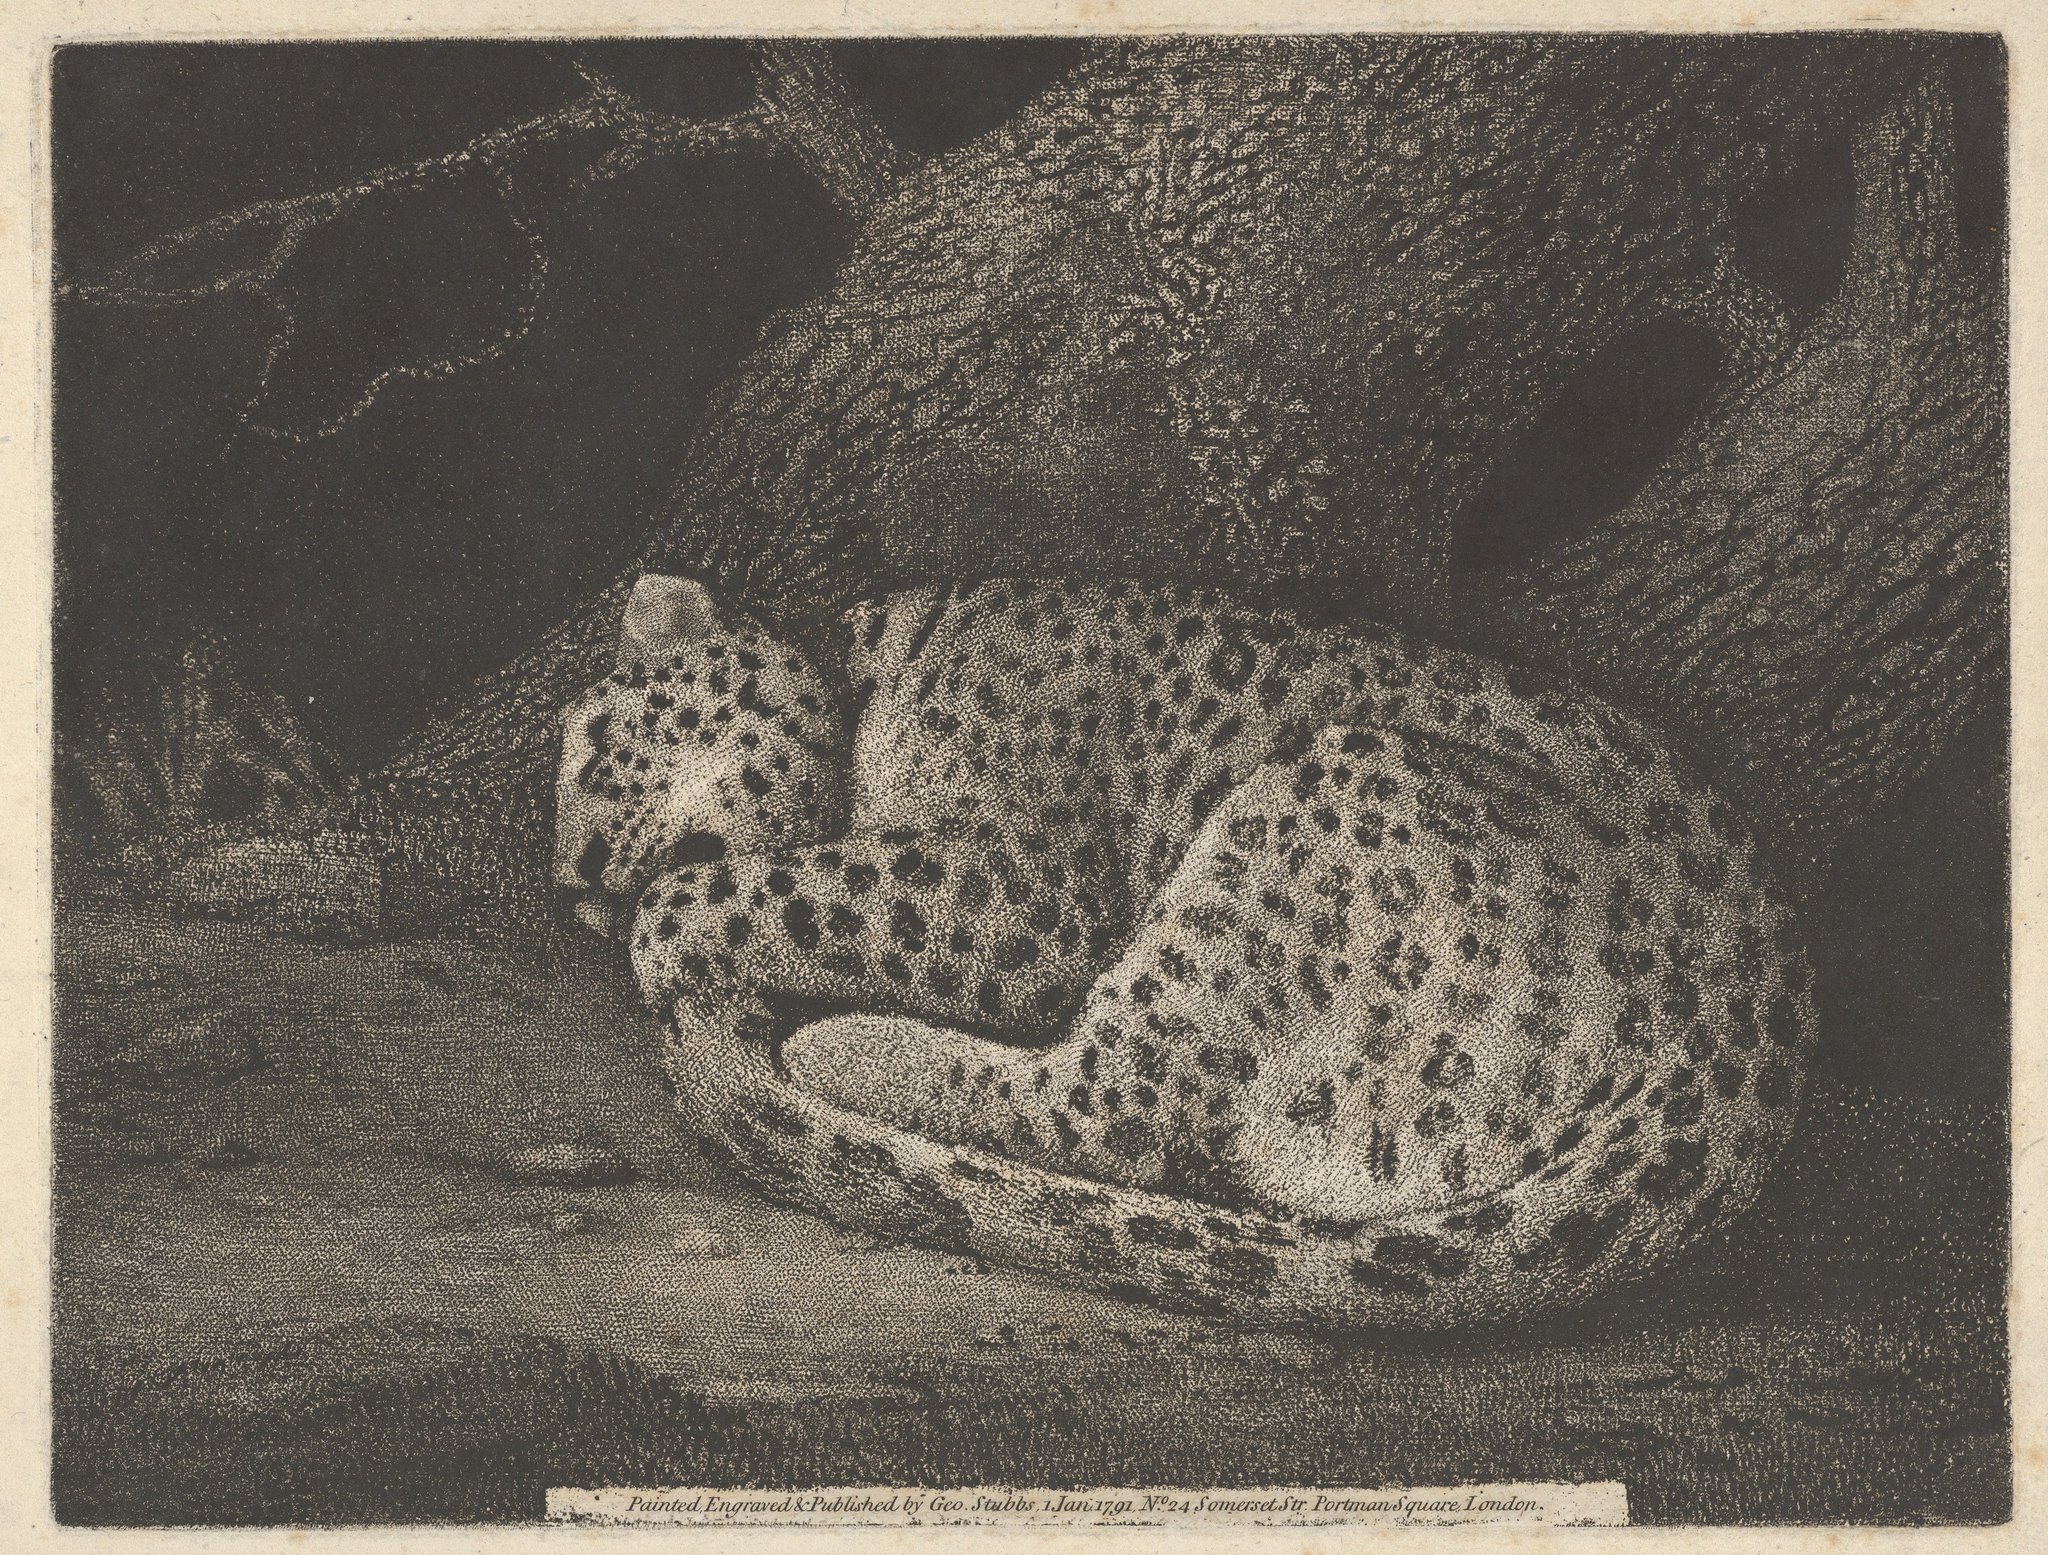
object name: print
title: A Sleeping Leopard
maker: george stubbs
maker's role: artist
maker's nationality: british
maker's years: 1724-1806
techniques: roulette, etching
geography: england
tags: leopards